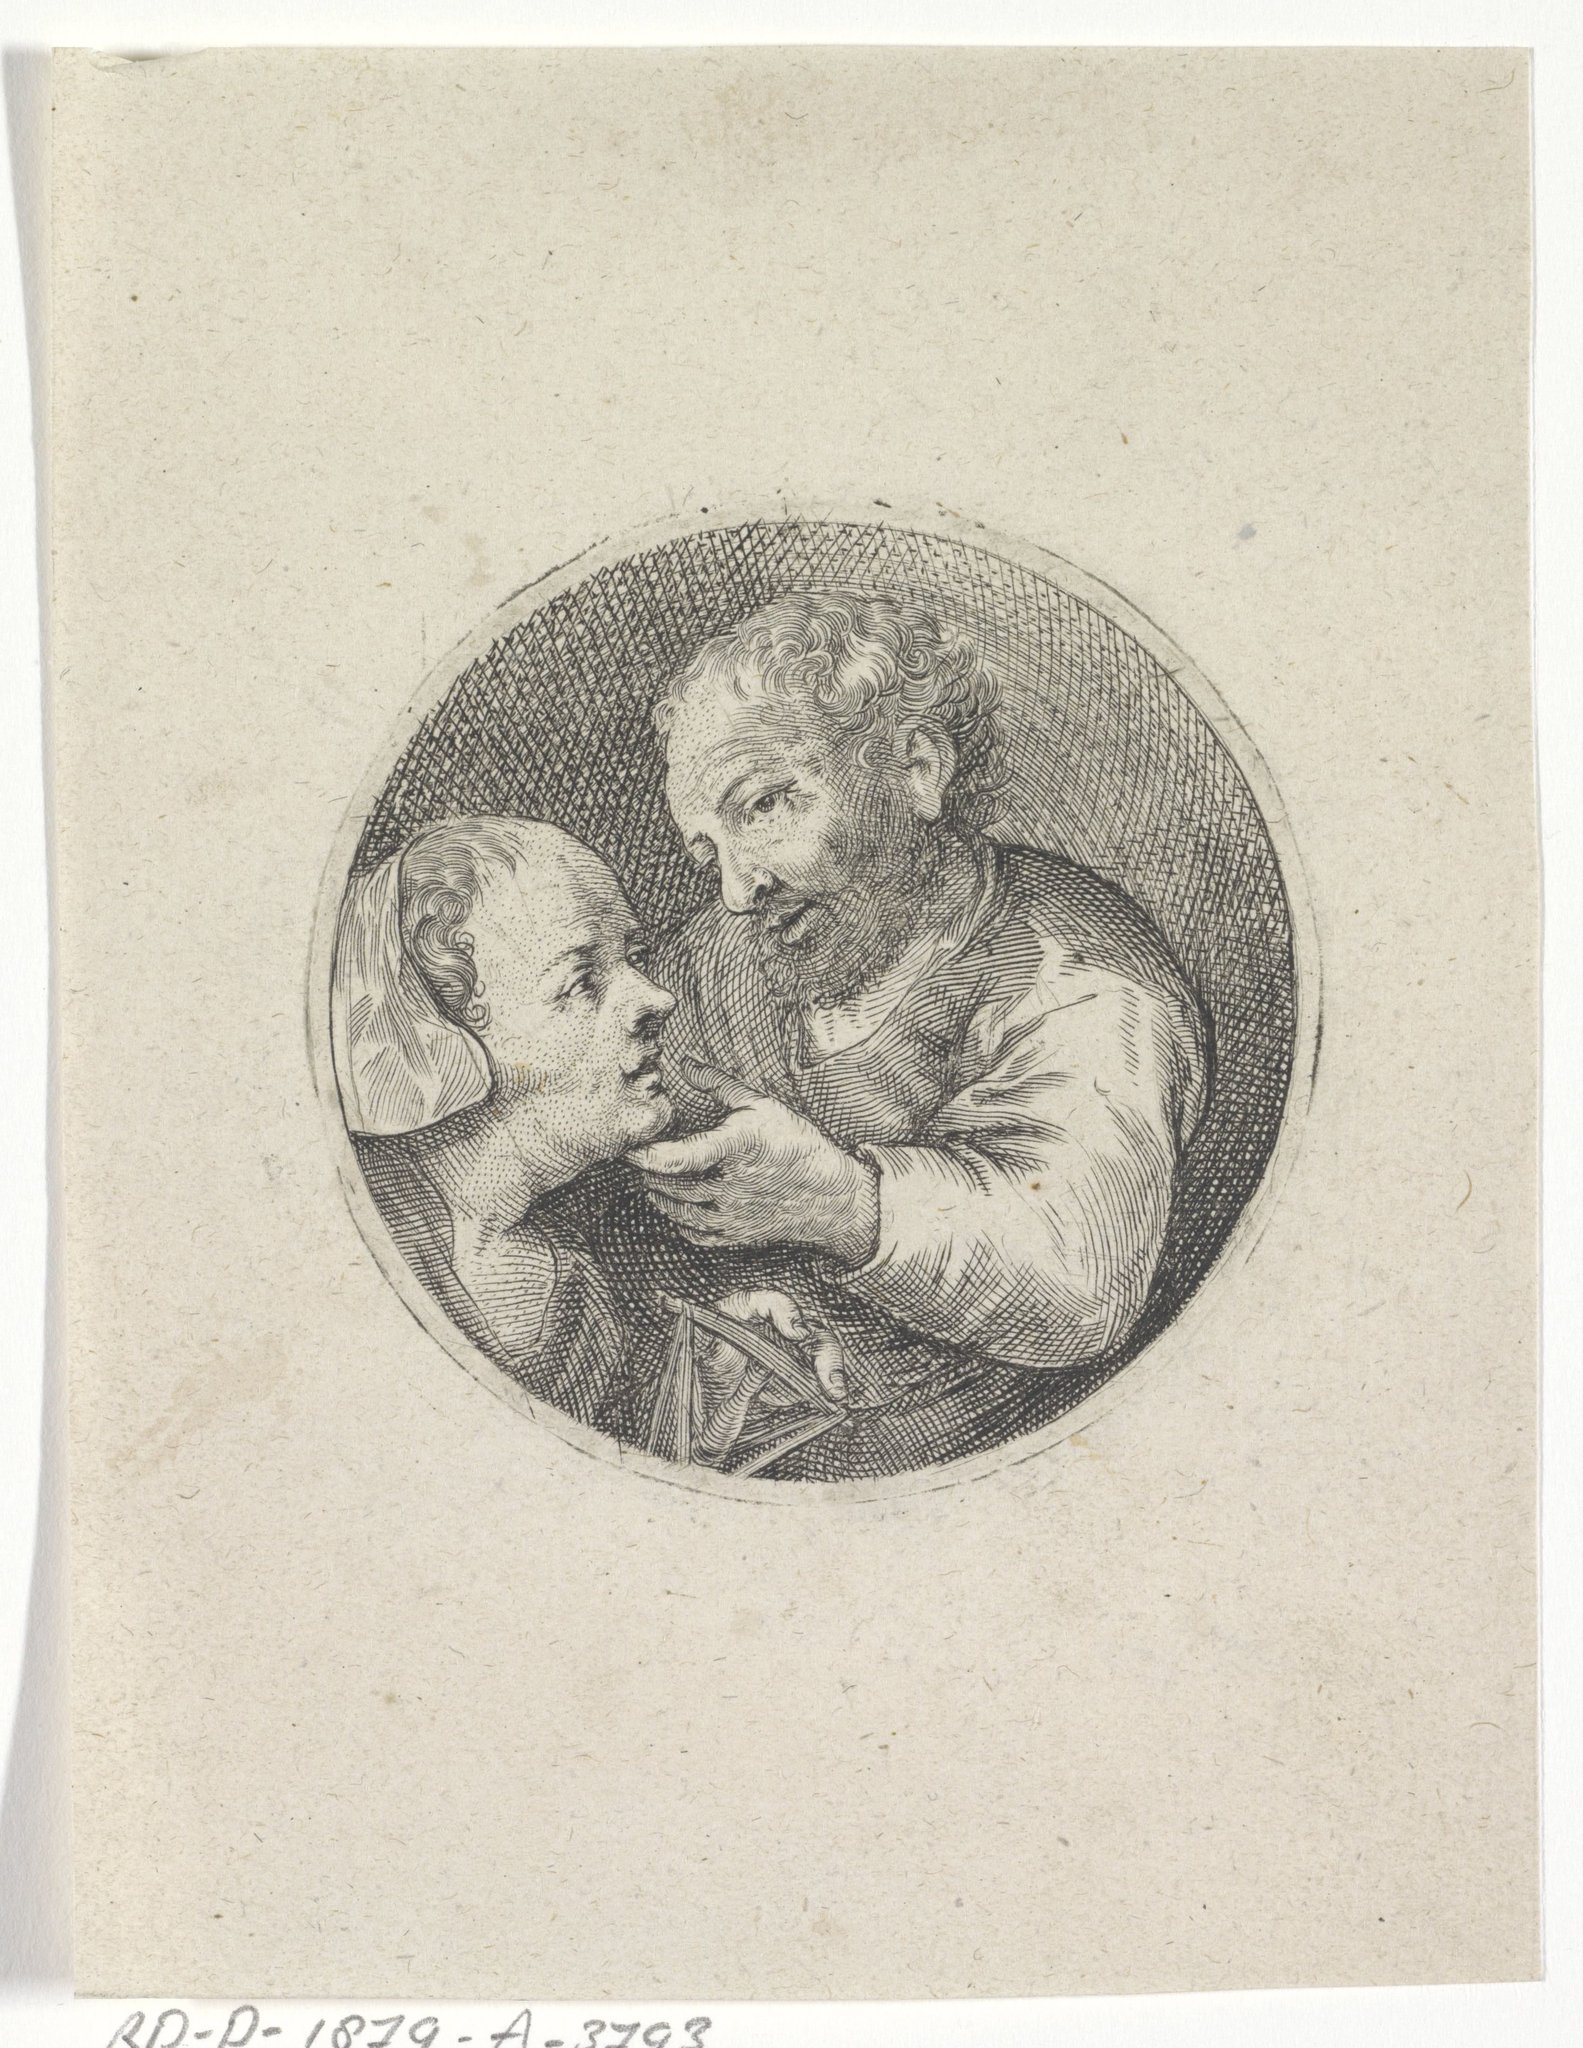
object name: print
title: Man streelt de kin van zijn vrouw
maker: Anonymous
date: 1580-1650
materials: paper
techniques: engraving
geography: netherlands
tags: couple of lovers, spinning (manufacture of yarn)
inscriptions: collector's mark: Lugt 2228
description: Een man met baard streelt de kin van een vrouw. Ze houdt een haspel in de hand.